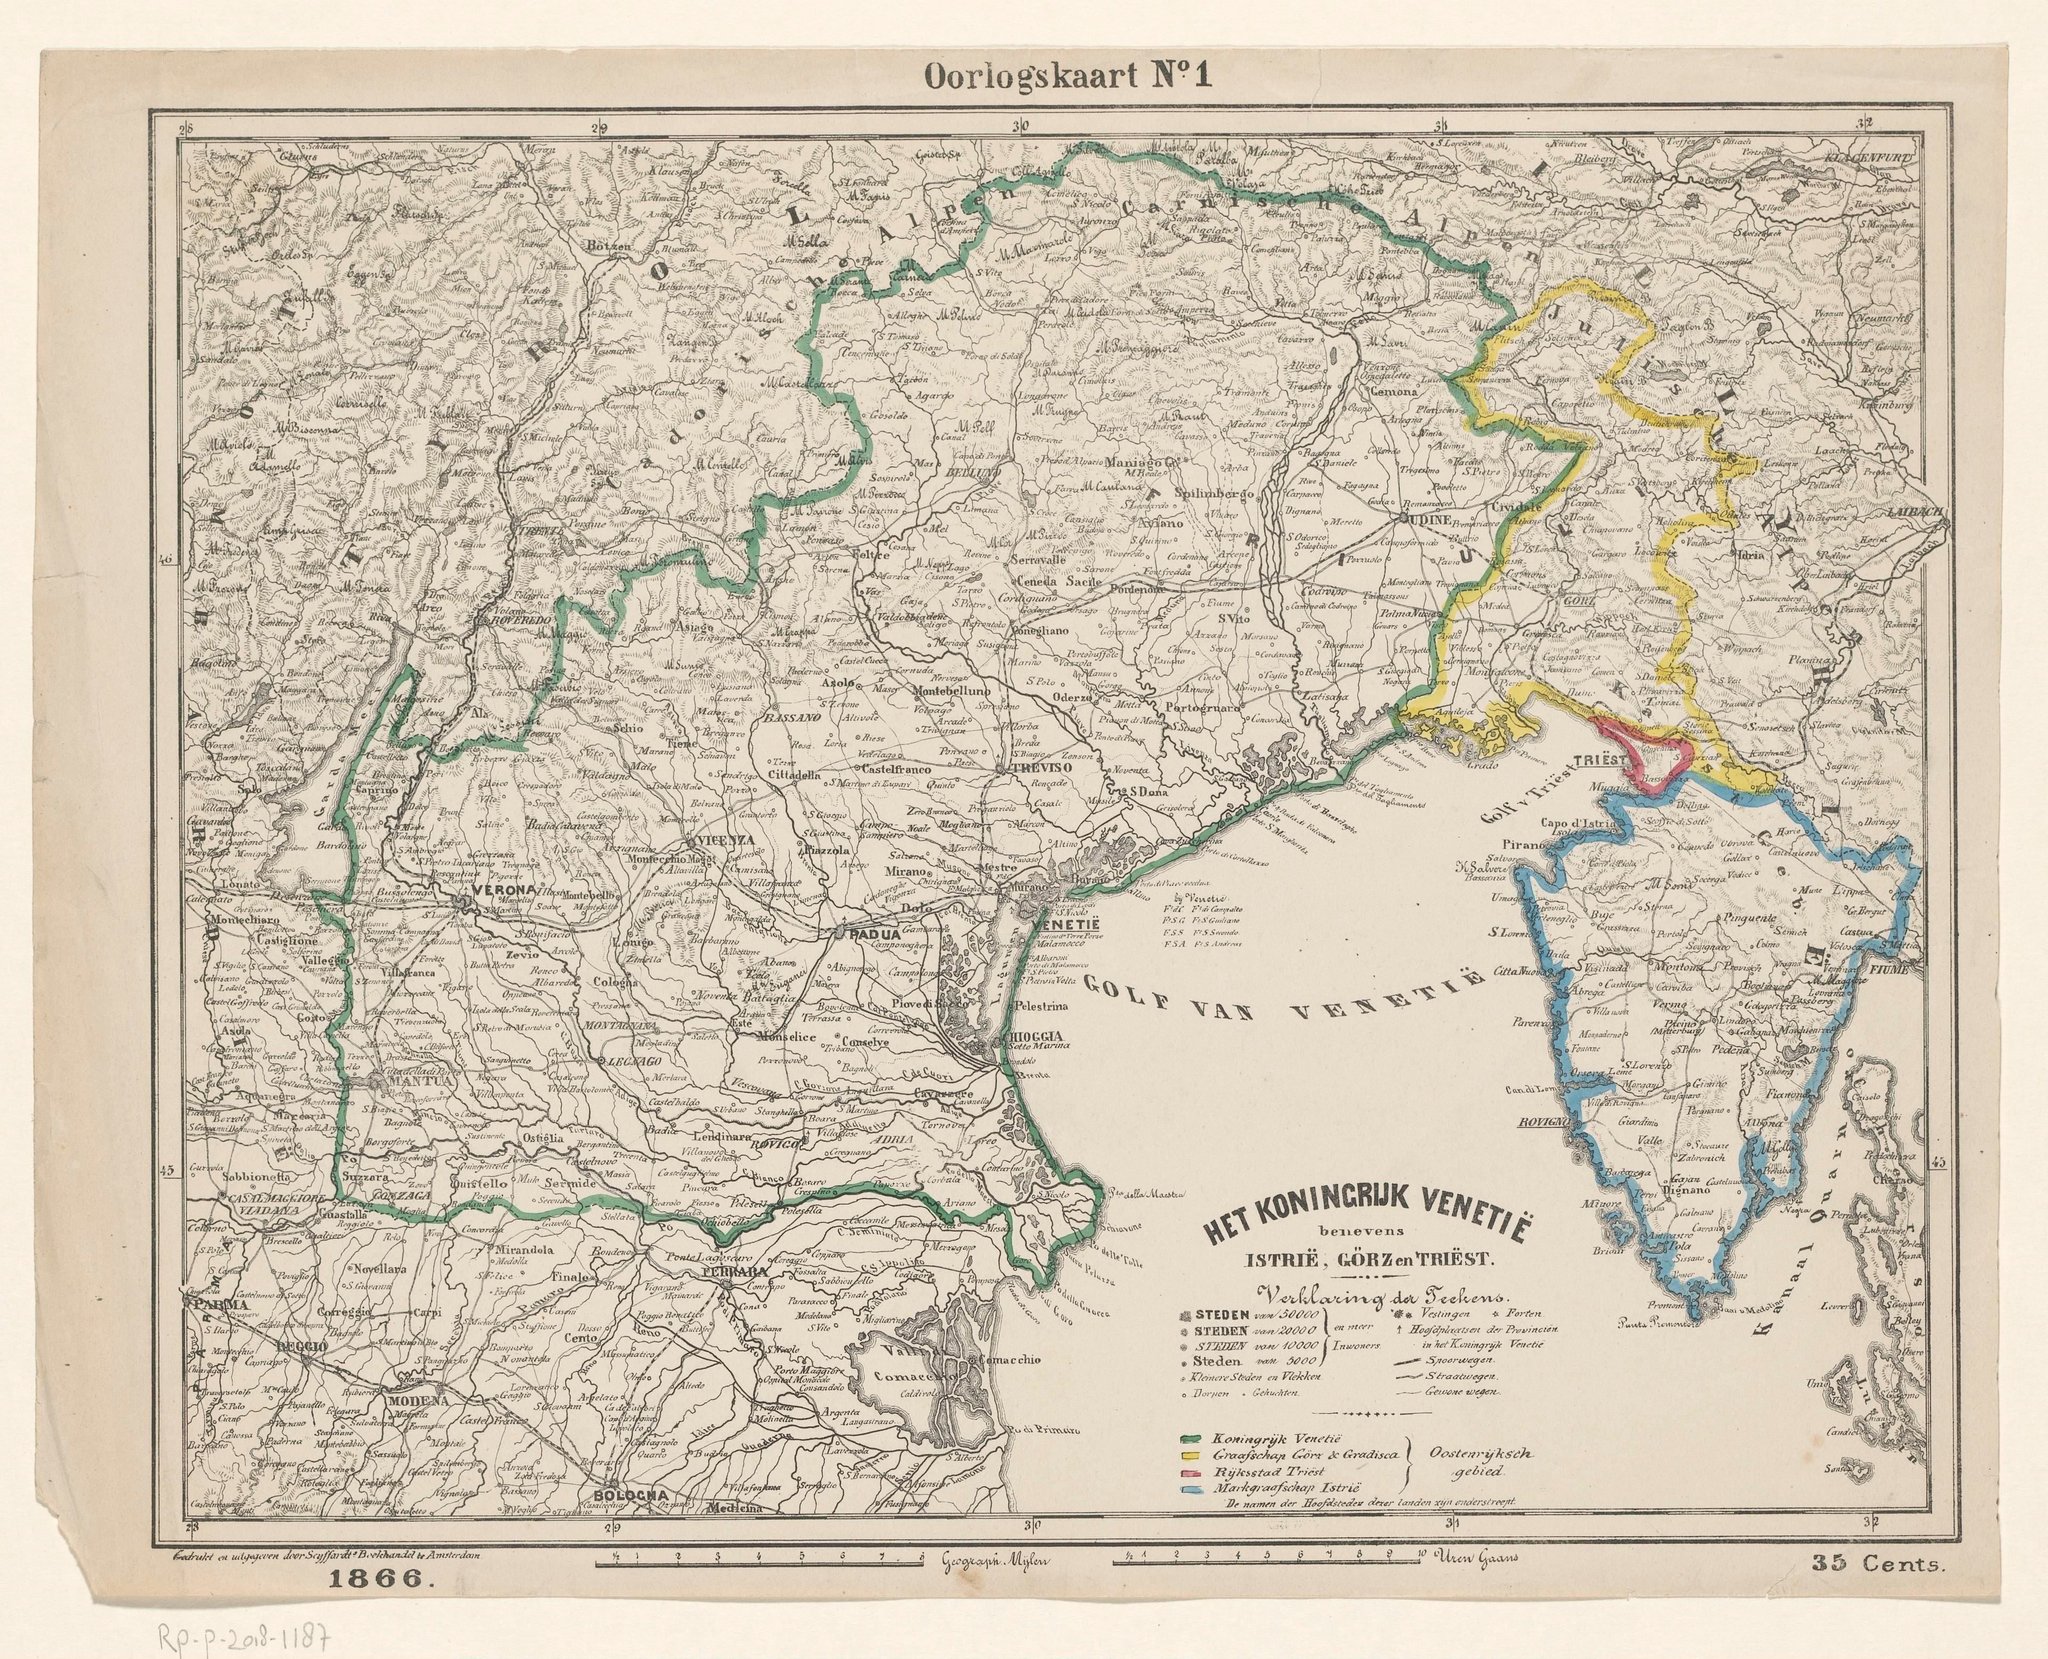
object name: print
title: Kaart van het Koninkrijk Lombardije-Venetië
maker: Anonymous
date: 1866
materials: paper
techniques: hand coloring, lithograph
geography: amsterdam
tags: maps of separate countries or regions